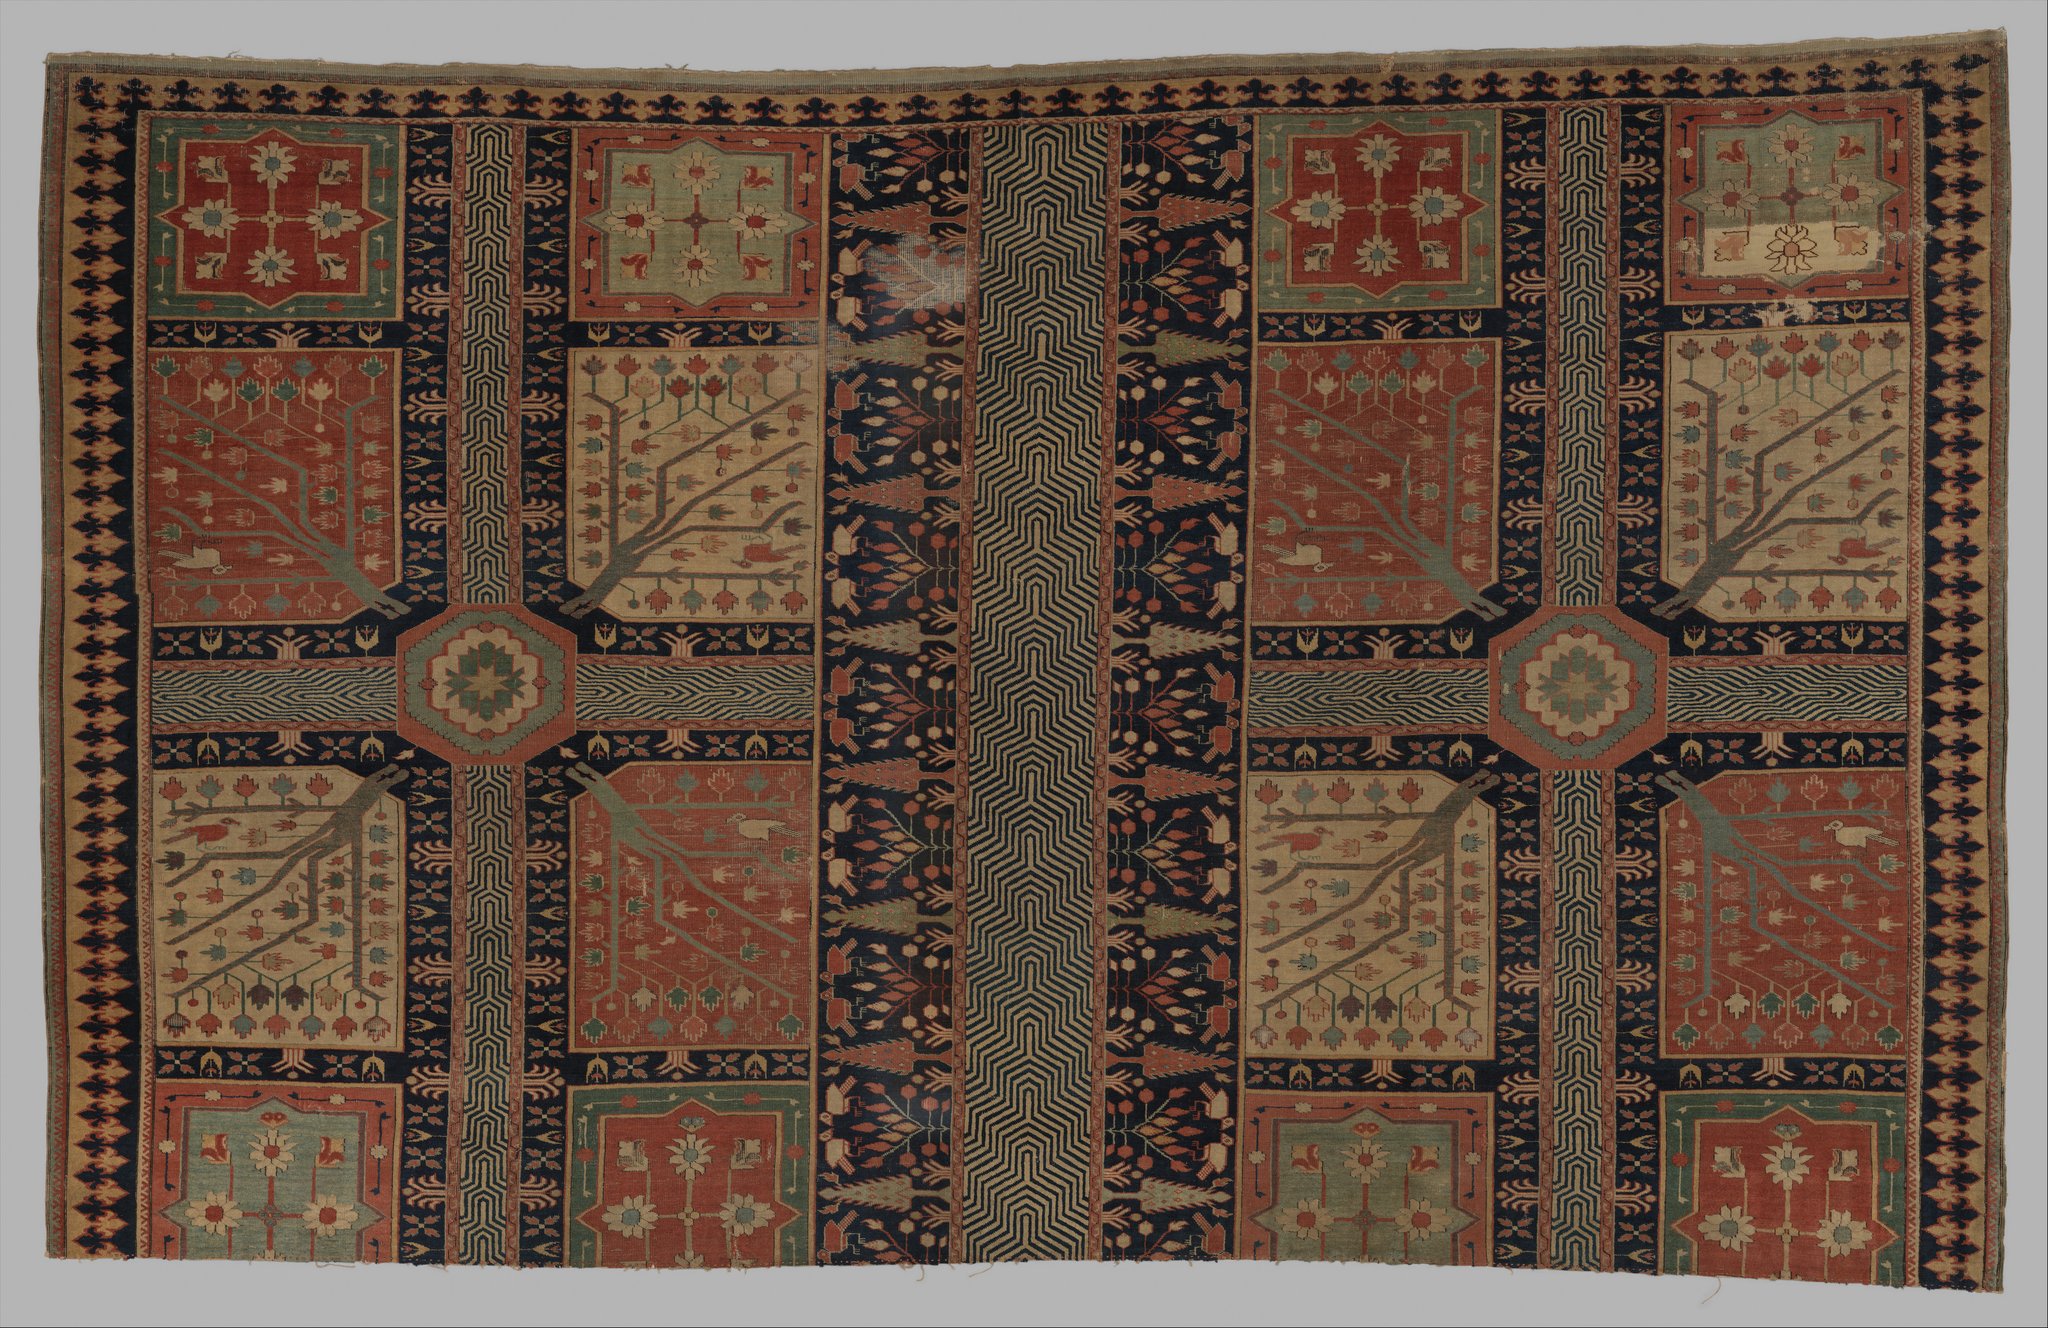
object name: carpet fragment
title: Fragment of a Garden Carpet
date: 1701-1800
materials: cotton, wool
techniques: pile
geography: iran